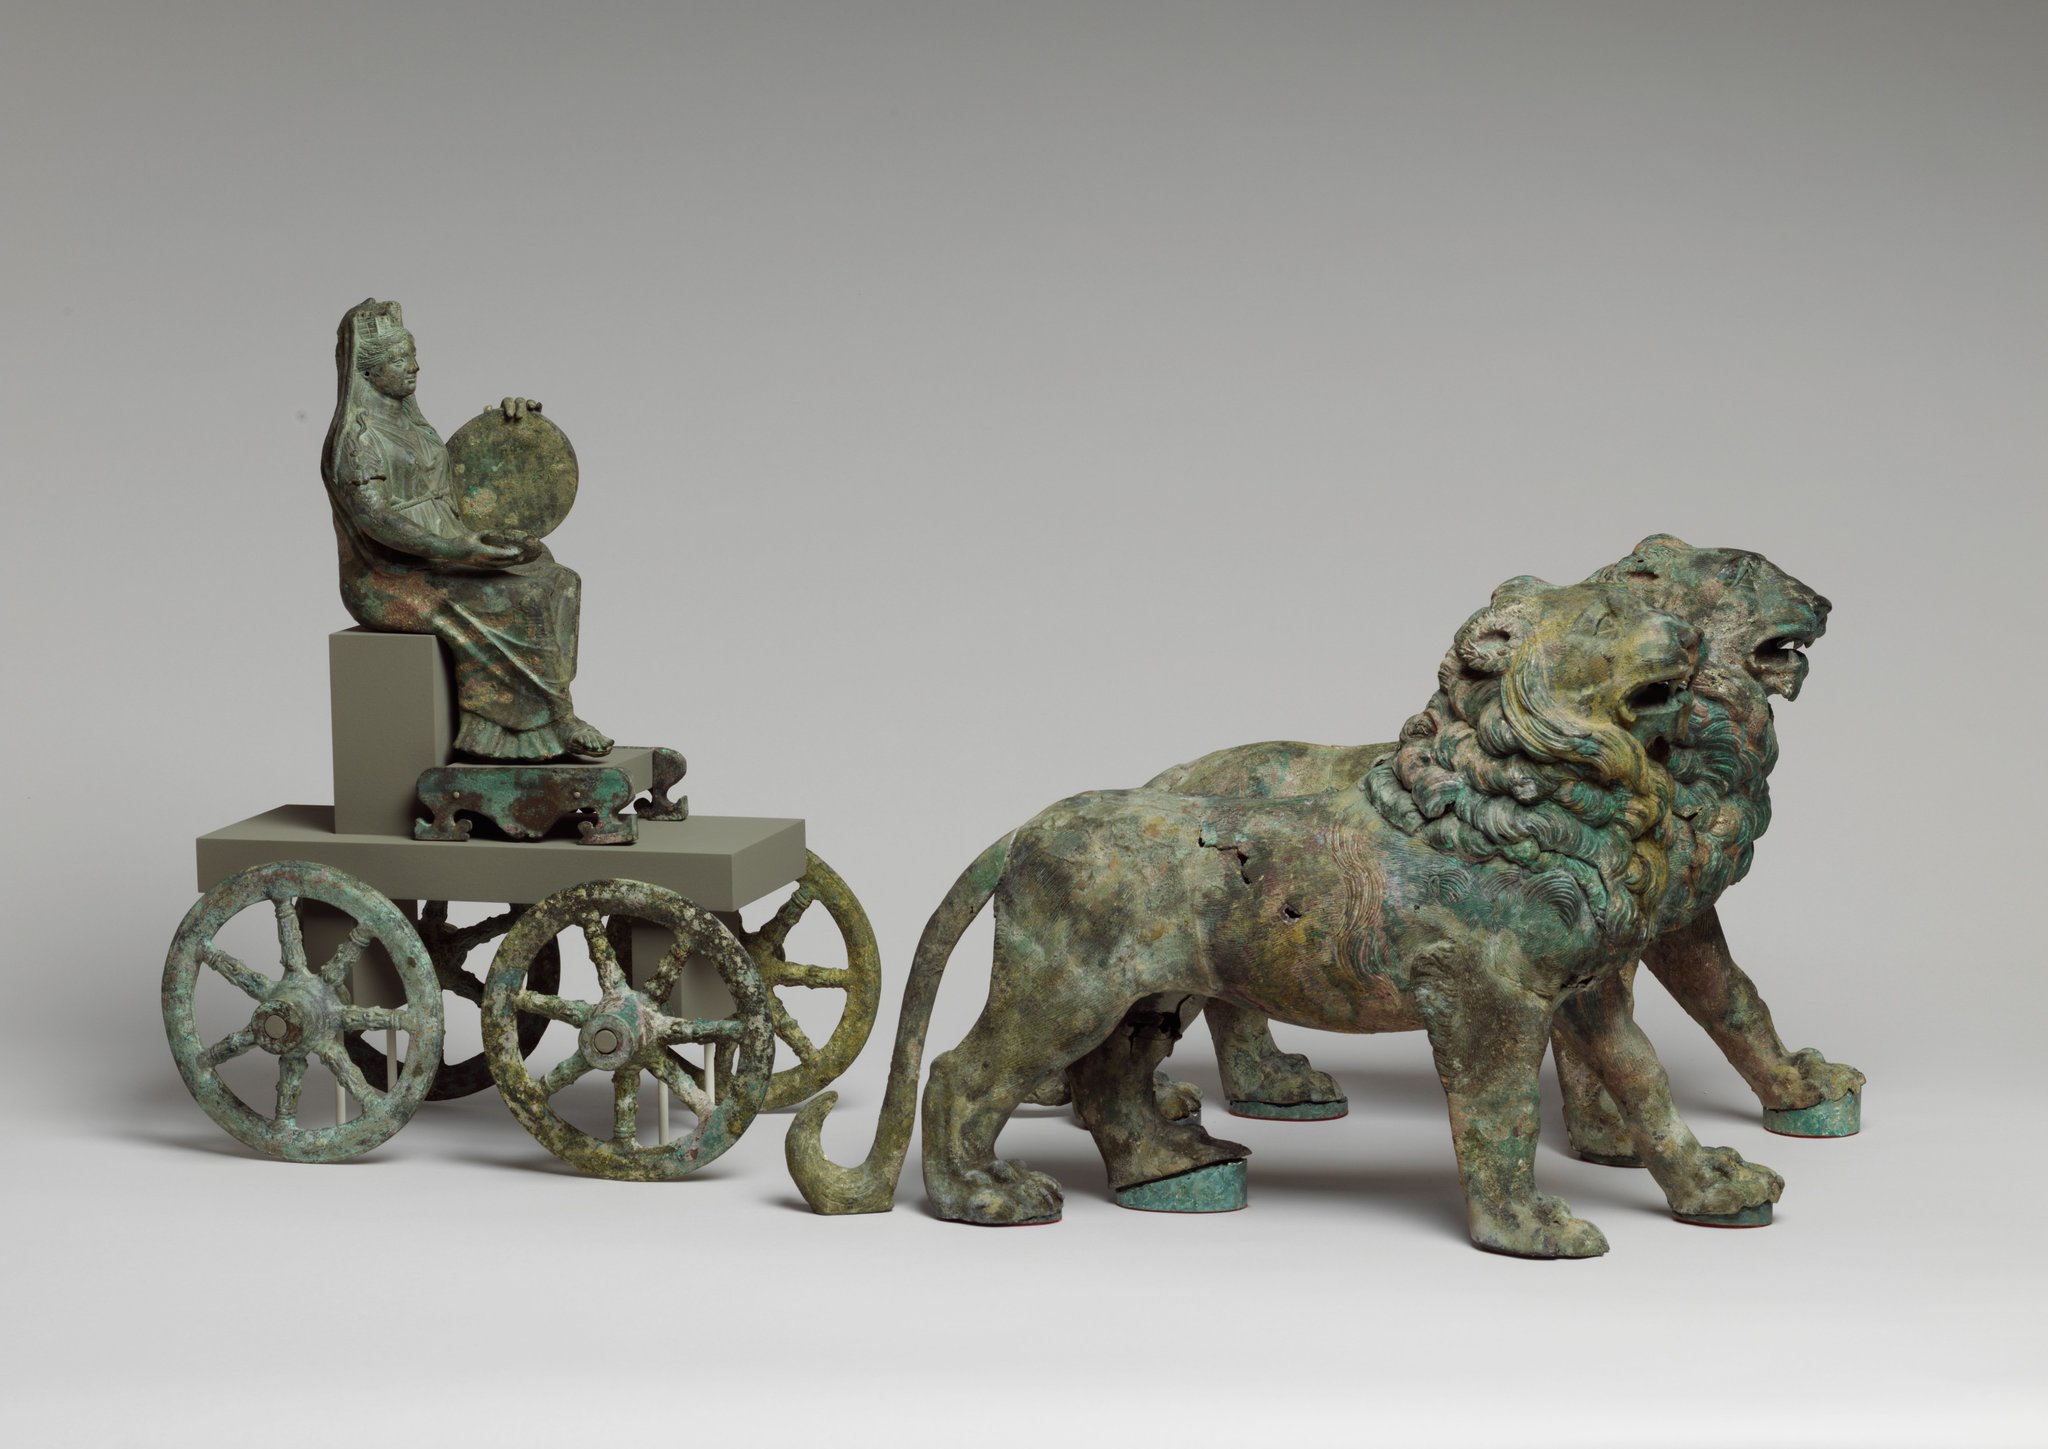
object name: cybele on a cart drawn by lion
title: Bronze statuette of Cybele on a cart drawn by lions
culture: roman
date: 151-200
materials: bronze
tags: lions,carts,cybele